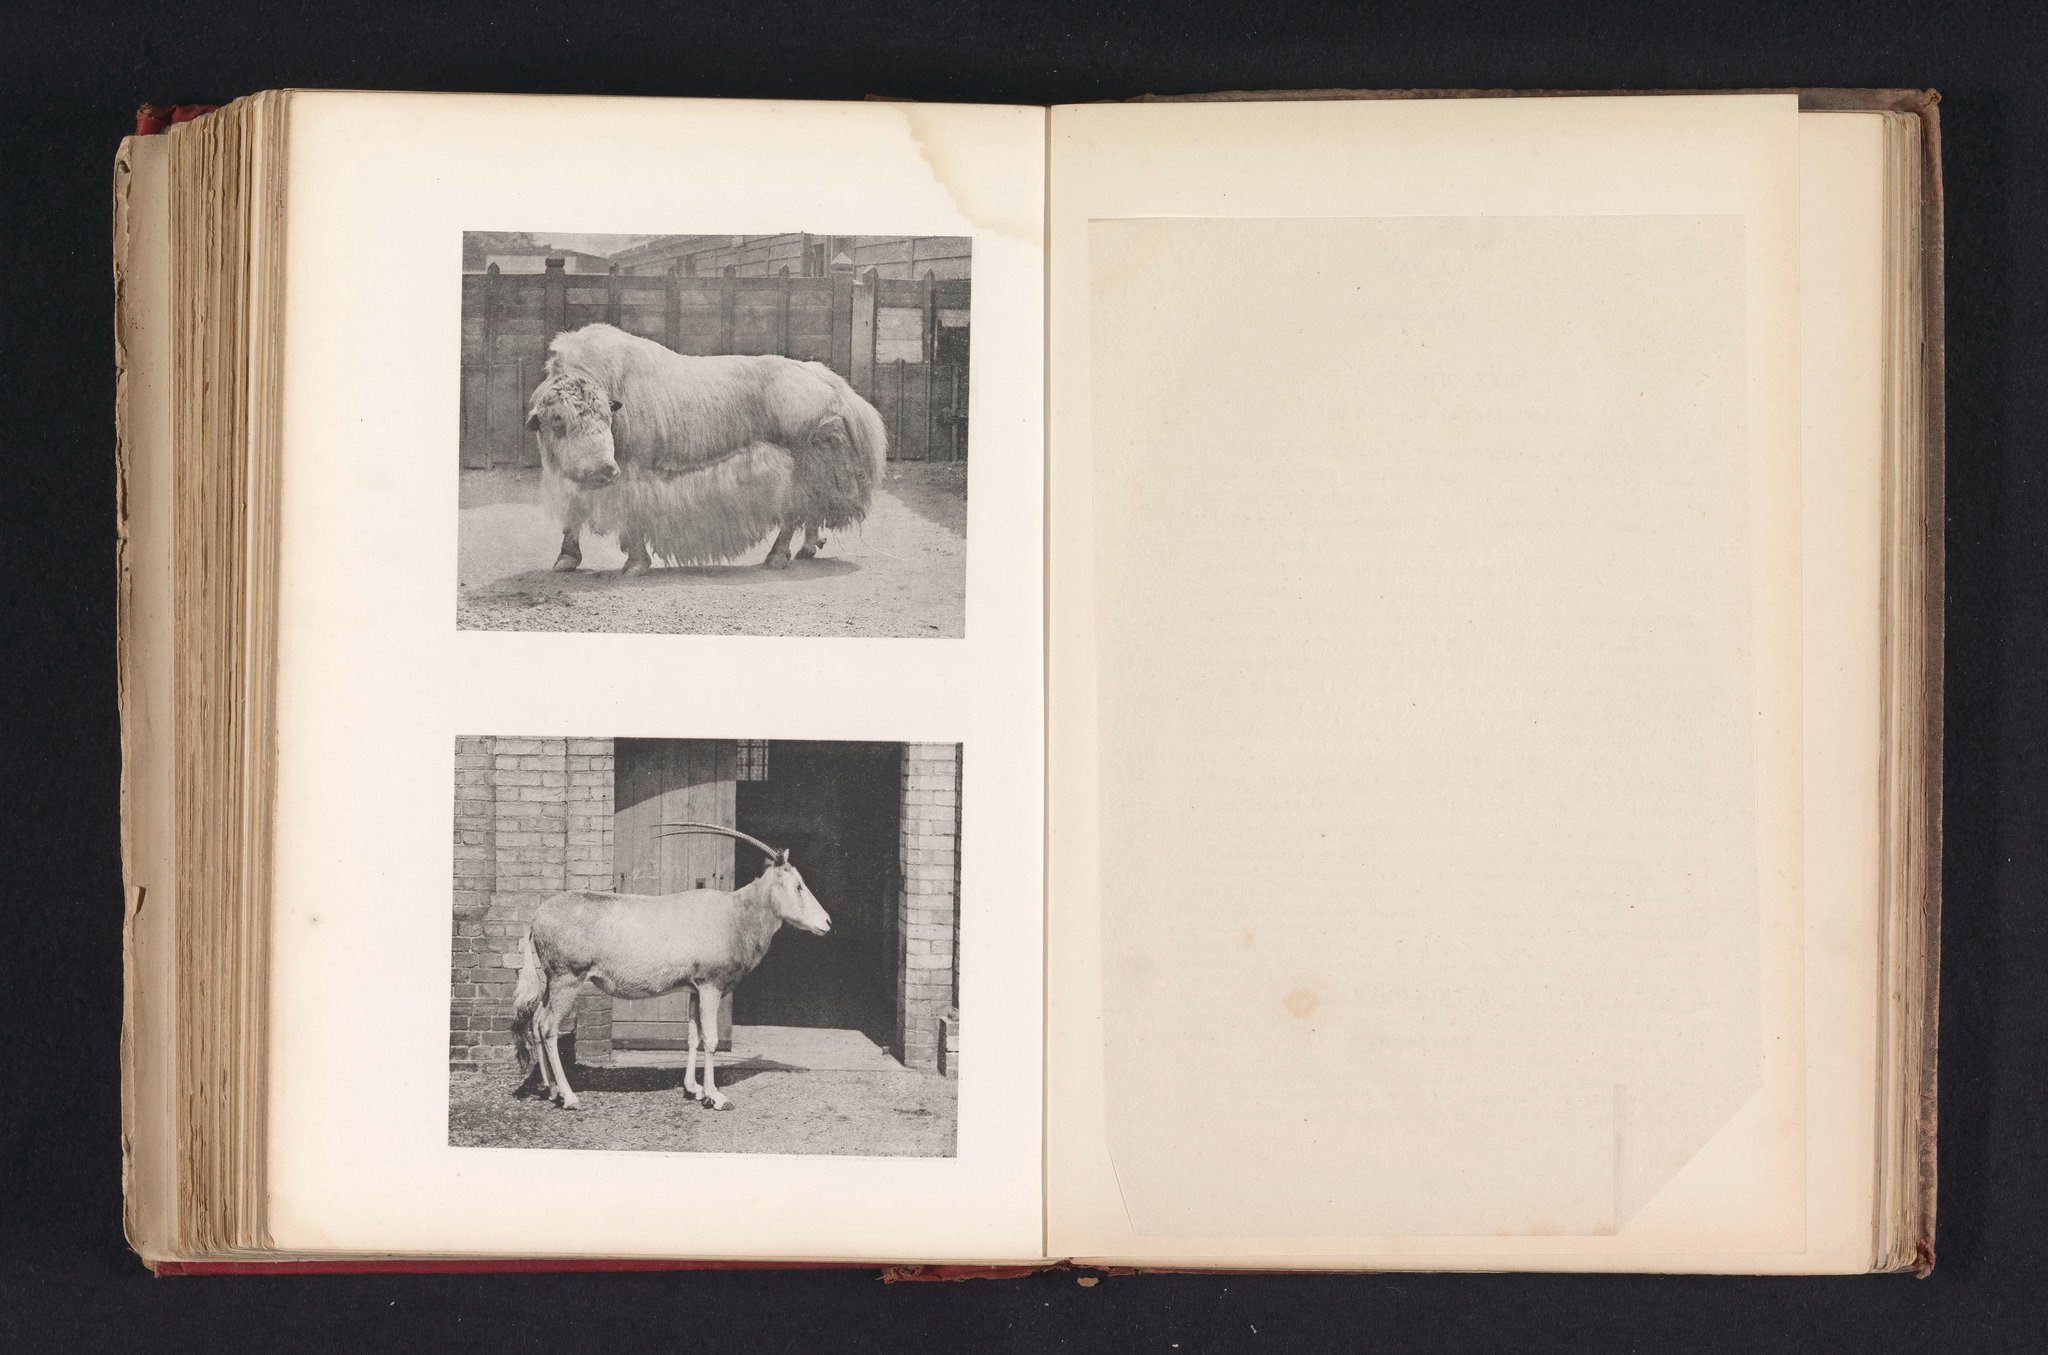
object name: photomechanical print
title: A yak, A leucoryx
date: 1876-1886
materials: paper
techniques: photograph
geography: paris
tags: hoofed animals: oryx, zoological garden, zoo, seen as place where non-domestic animals are kept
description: Boven een jak, onder een Arabische oryx.